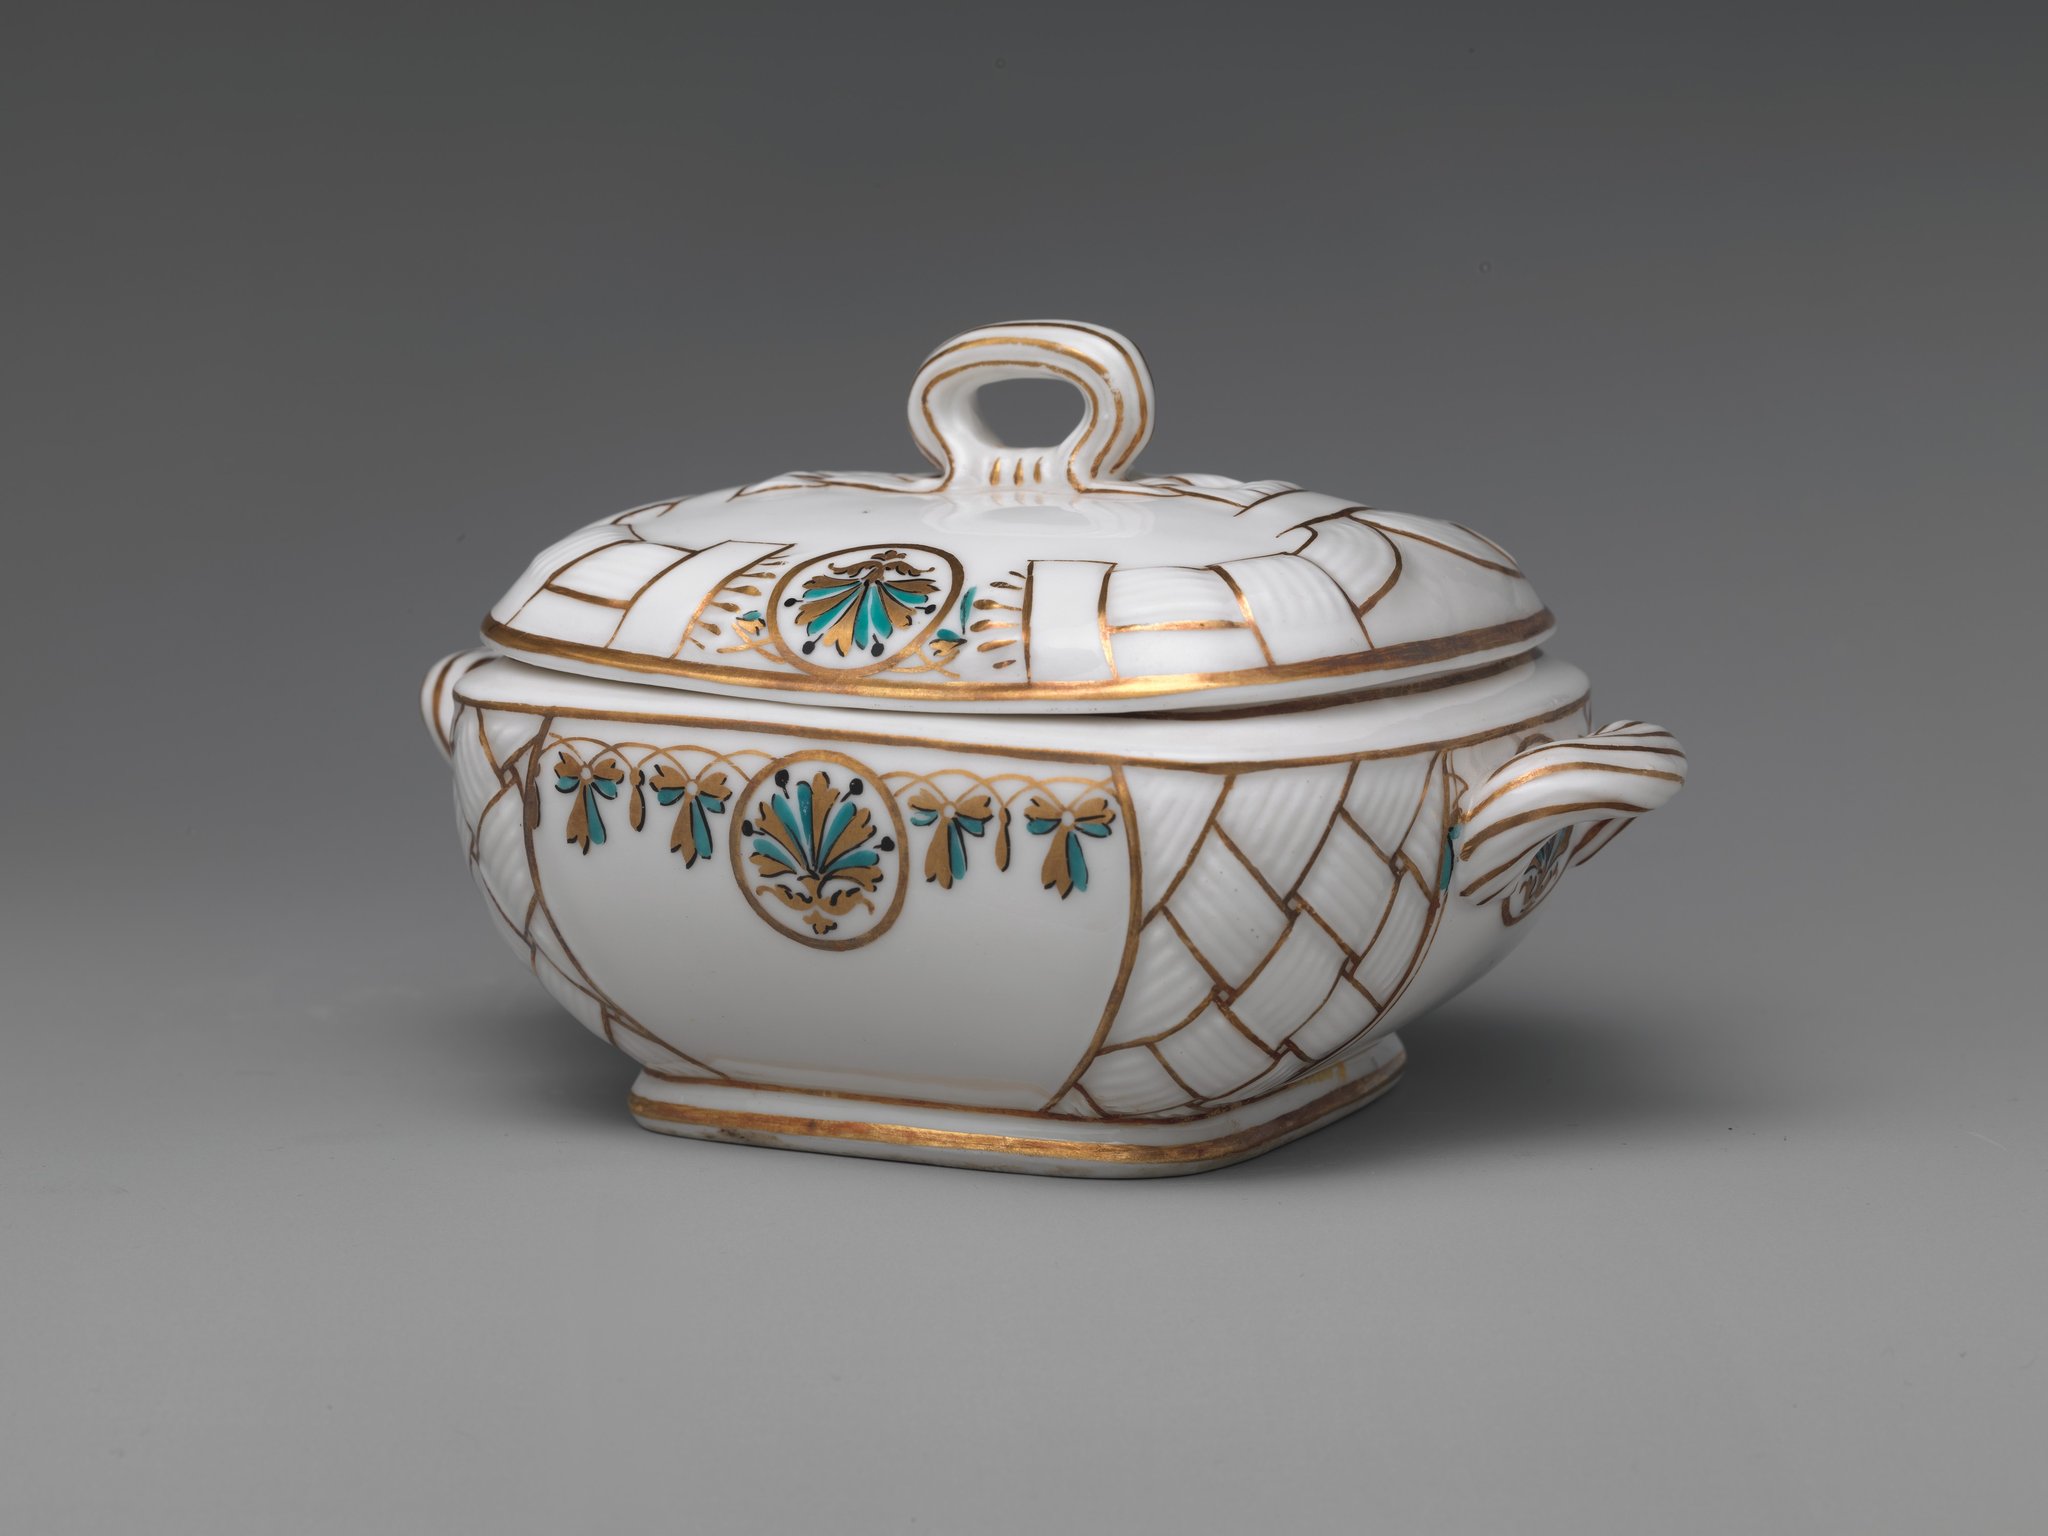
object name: sugar bowl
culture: american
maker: union porcelain works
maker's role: maker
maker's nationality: american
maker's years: 1863-1922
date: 1885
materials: porcelain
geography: united states